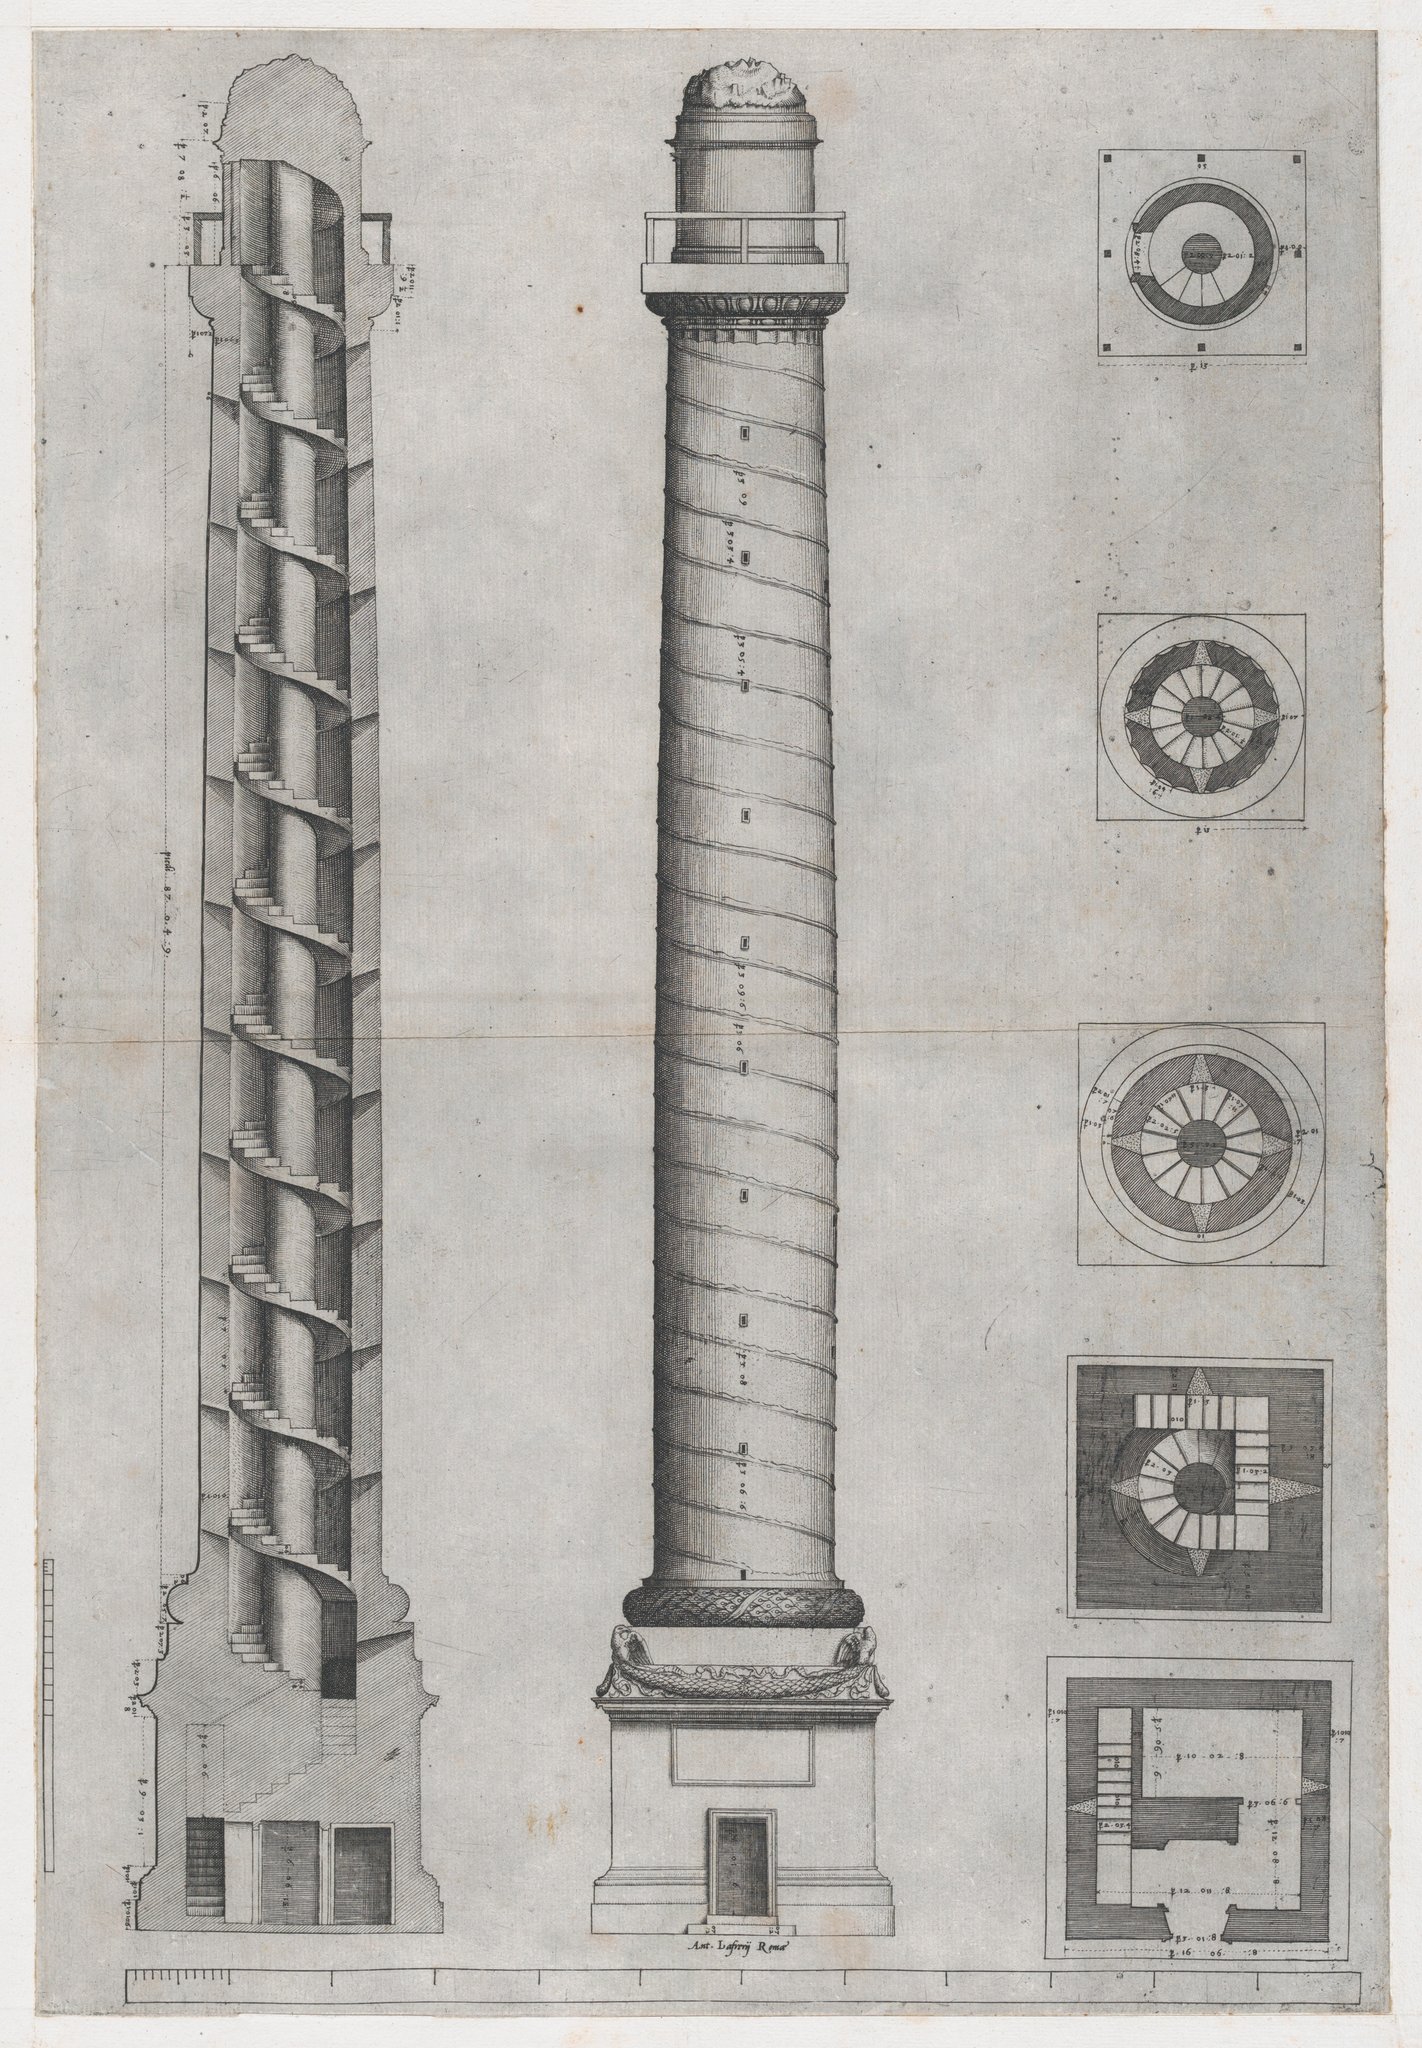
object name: print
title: The Column of Trajan, from "Speculum Romanae Magnificentiae"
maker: anonymous, italian, 16th century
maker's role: artist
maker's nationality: italian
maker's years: 1500-1600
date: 1501-1600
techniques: engraving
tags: architecture,columns,rome